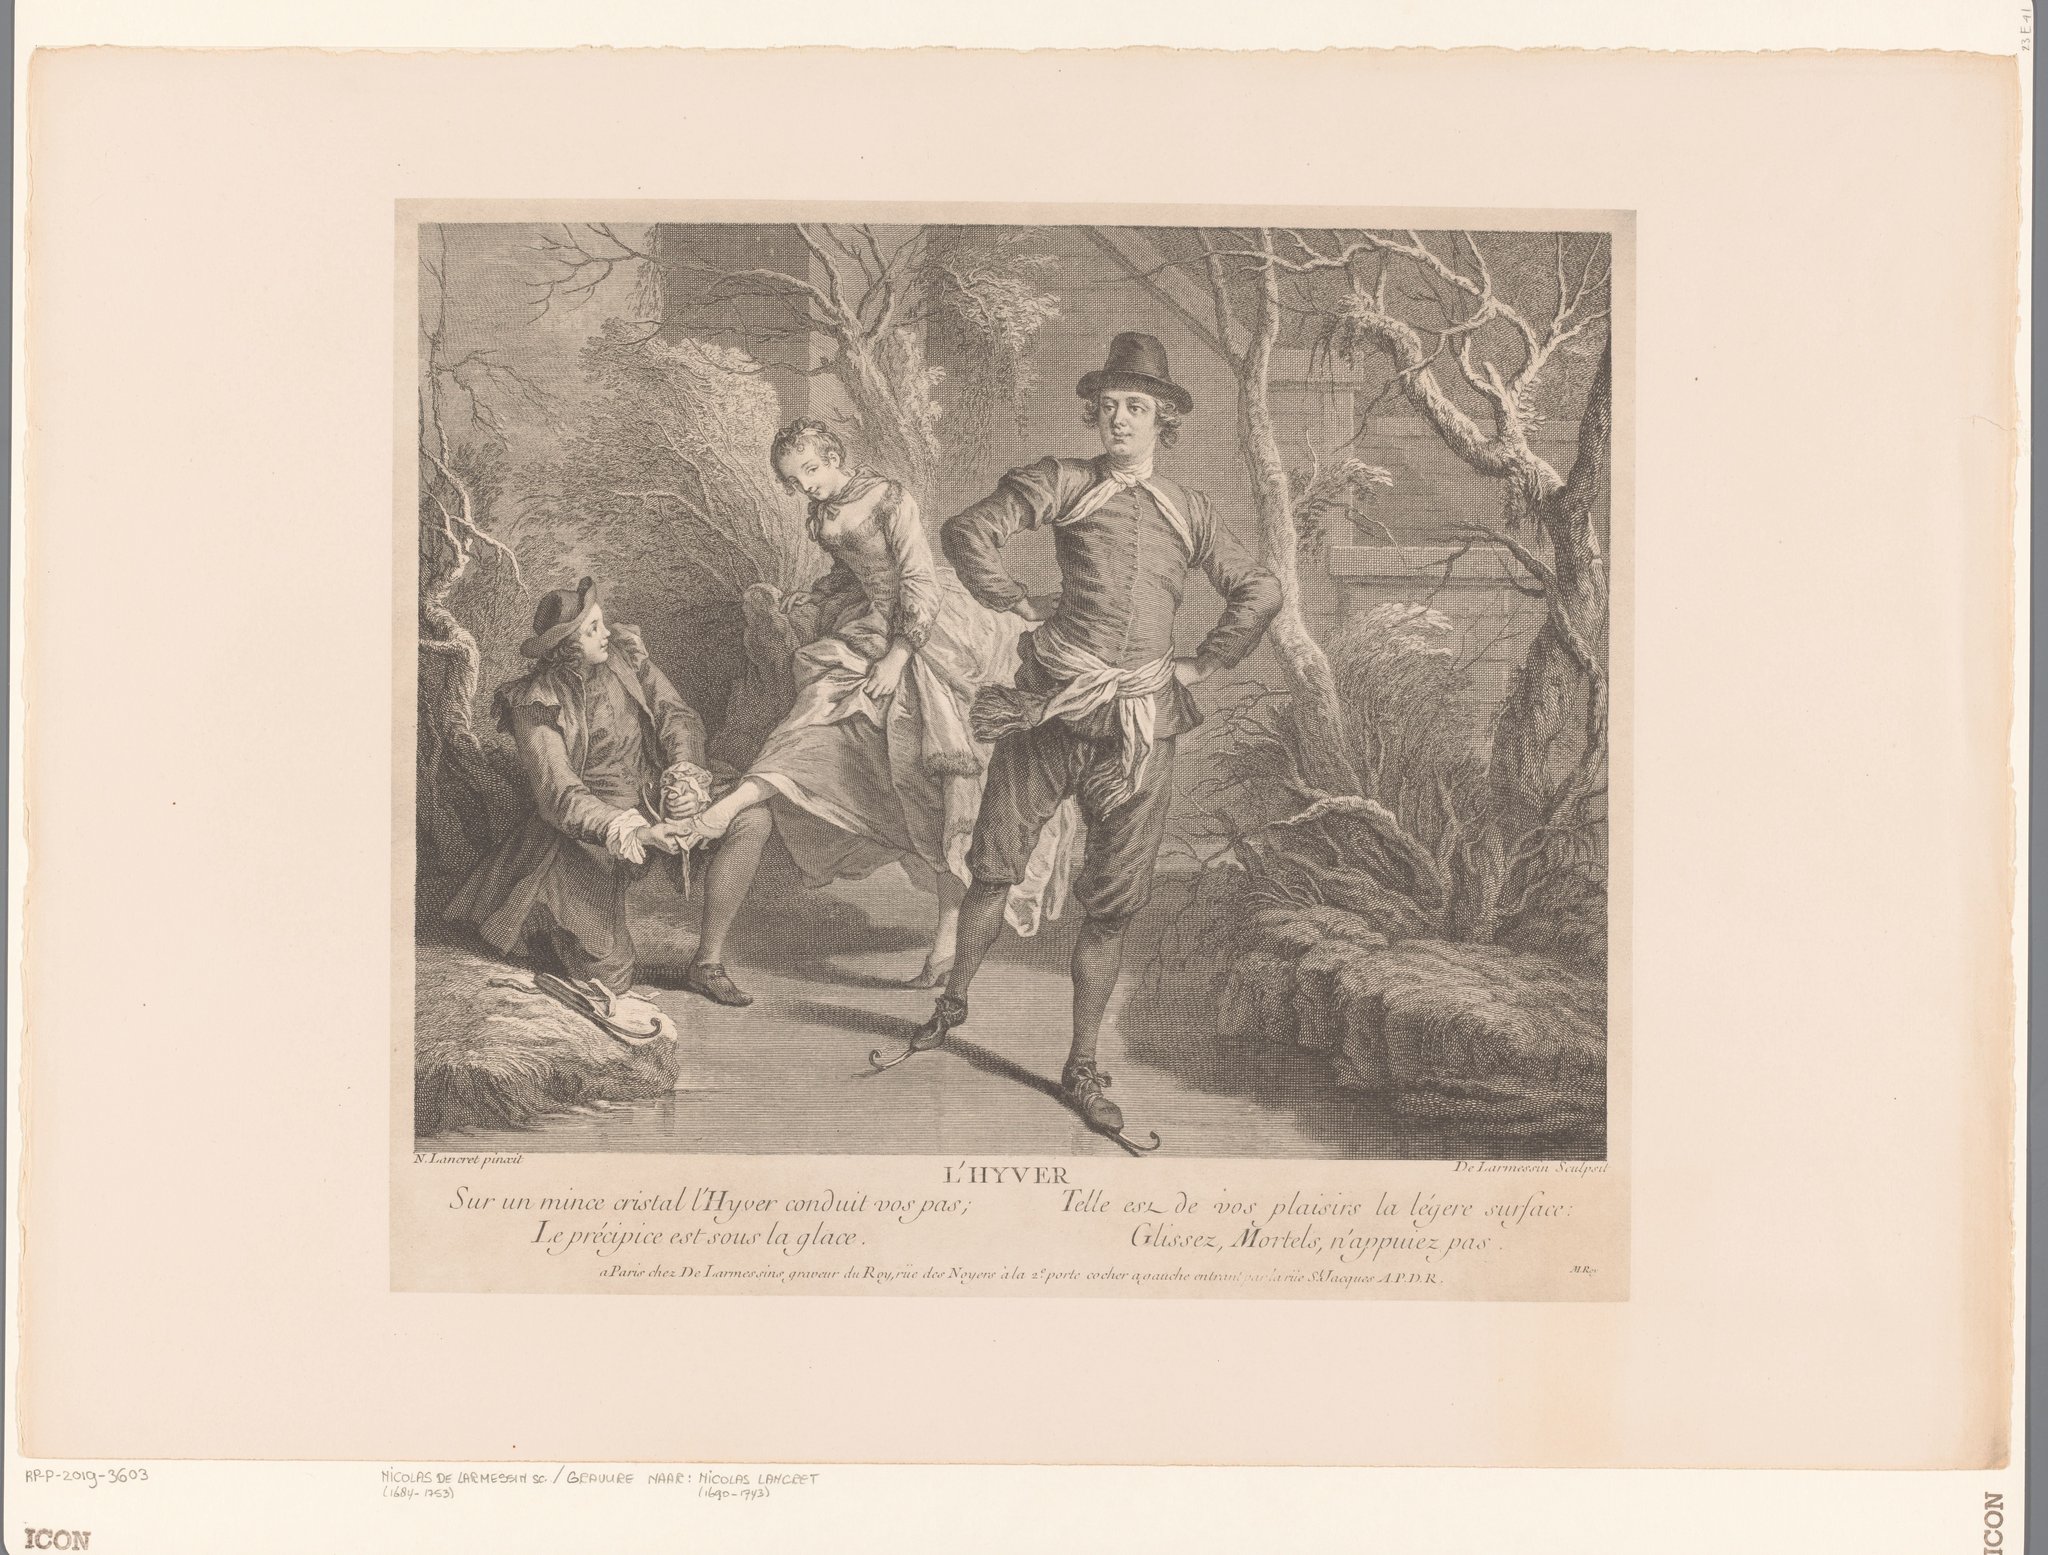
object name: photomechanical print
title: Les Quatre Saisons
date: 1912-1961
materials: paper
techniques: photograph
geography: amsterdam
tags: winter ~ human activities (the four seasons of the year), skates (winter sports)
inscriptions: collector's mark: Lugt 2228, annotation: ‘Uitgave Gebr. Graauw/ Singel/ Amsterdam’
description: Schaatsende man op een bevroren sloot, met links een andere man die een vrouw haar schaatsen ombindt.